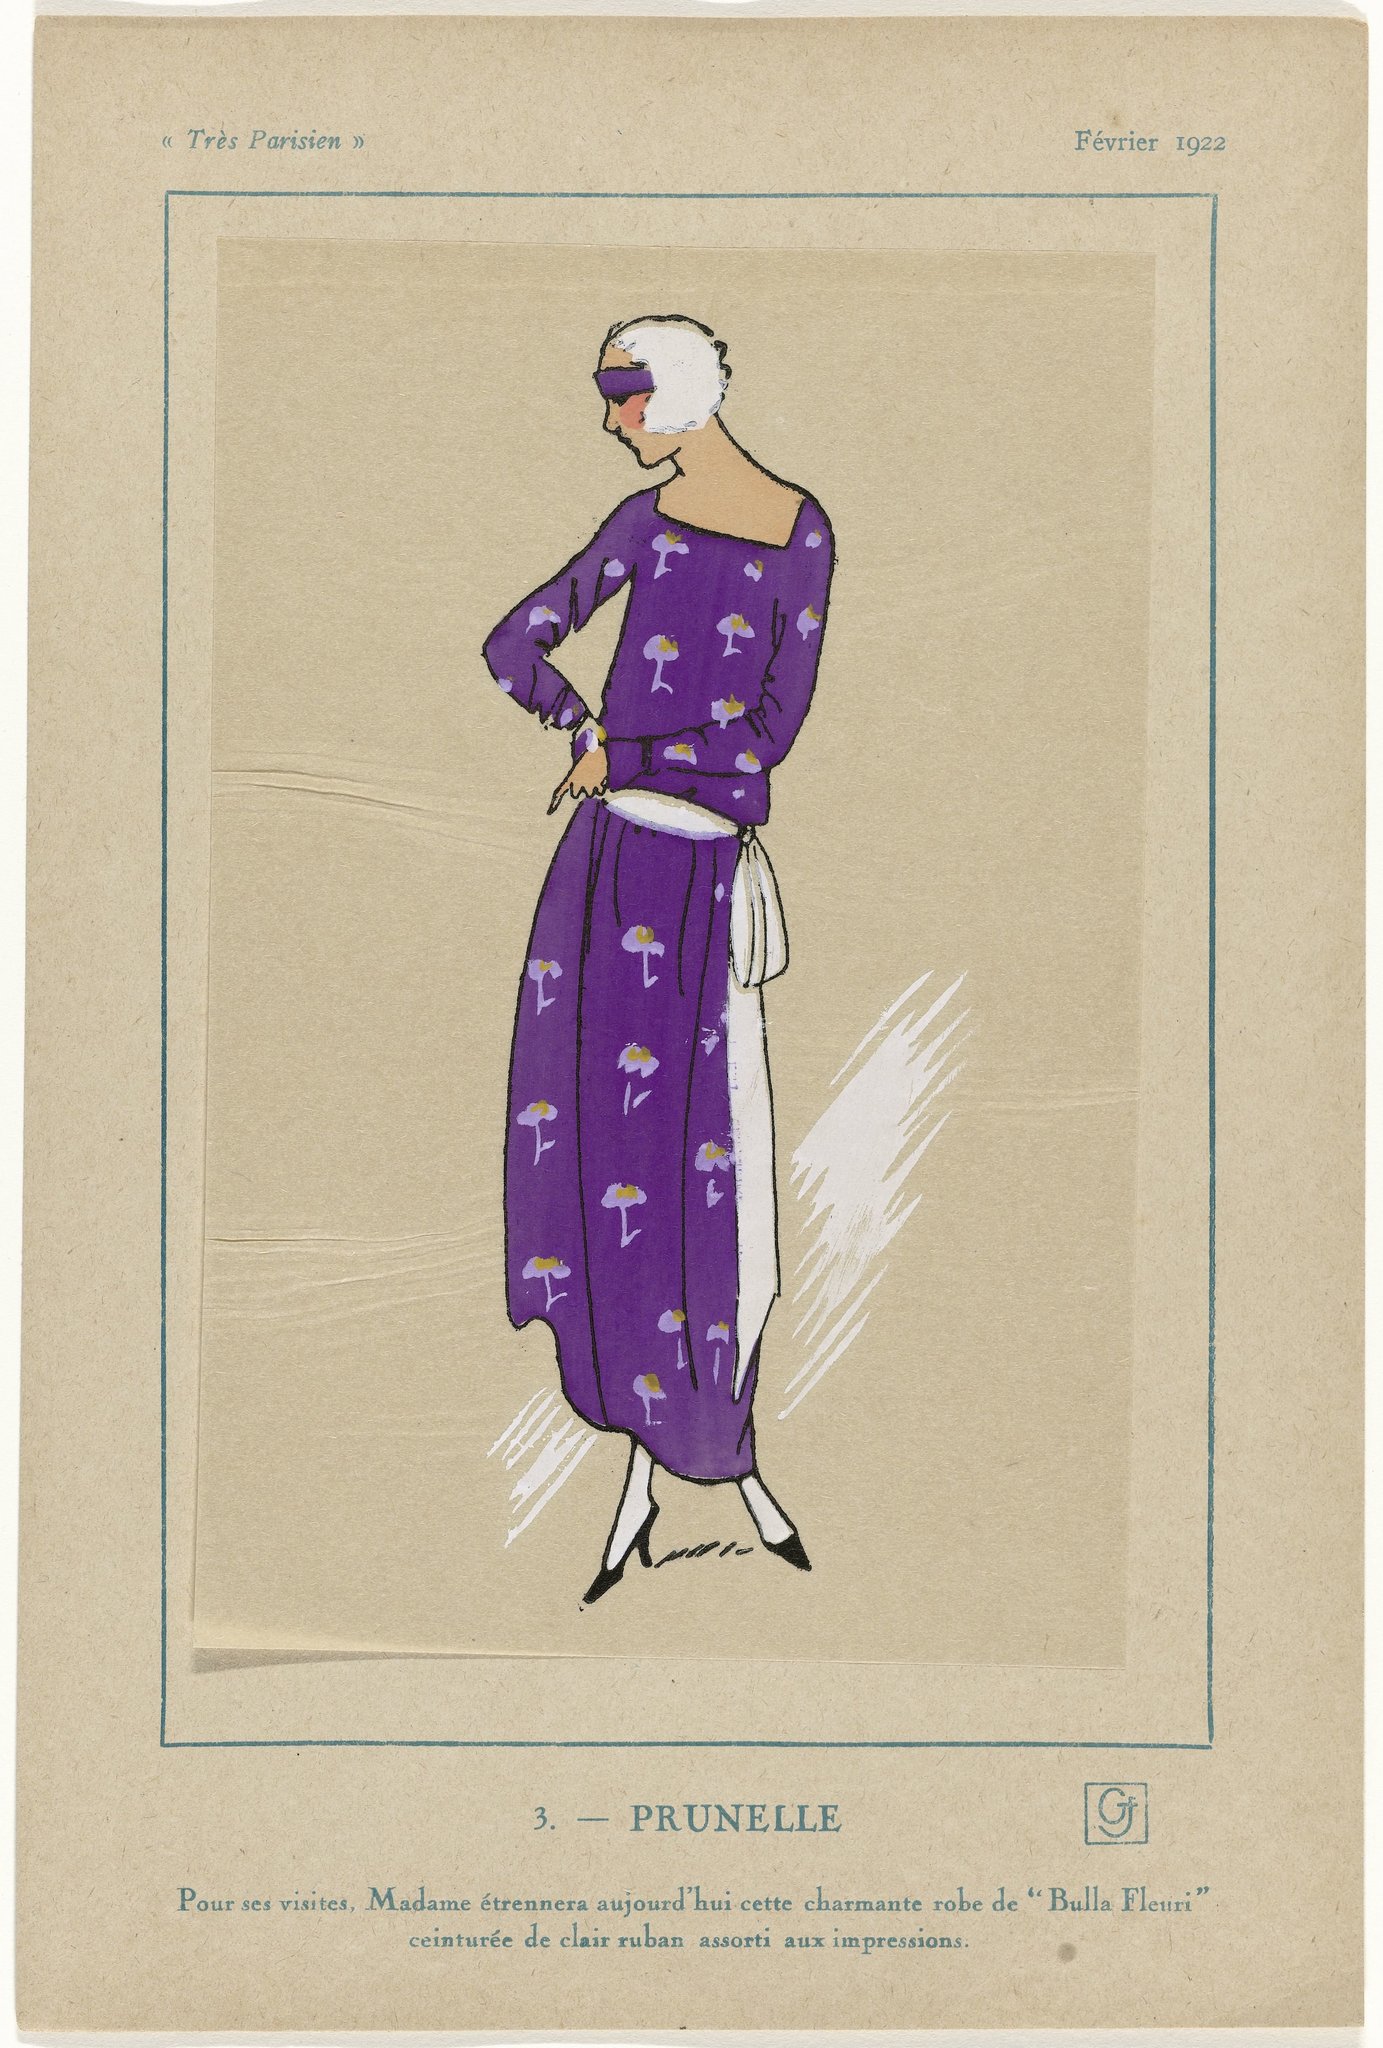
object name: fashion print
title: Très Parisien, février 1922: 3.- PRUNELLE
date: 1922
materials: paper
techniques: hand coloring, letterpress printing, lithography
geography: paris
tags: diadem, tiara (+ women's clothes), border, ribbon, braid (+ women's clothes), dress, gown (visiting dress) (+ women's clothes), fashion plates, belt, girdle, waistband (+ women's clothes)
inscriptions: caption: ‘3. - PRUNELLE / Pour ses visites, Madame étrennera aujourd'hui cette charmante robe de "Bulla fleuri" ceinturée de clair ruban assorti aux impressions.’, title: ‘Très Parisien / Février 1922’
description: Een paarse "Bulla fleuri' middagjapon met witte ceintuur. Prent uit het modetijdschrift Très Parisien (1920-1936).